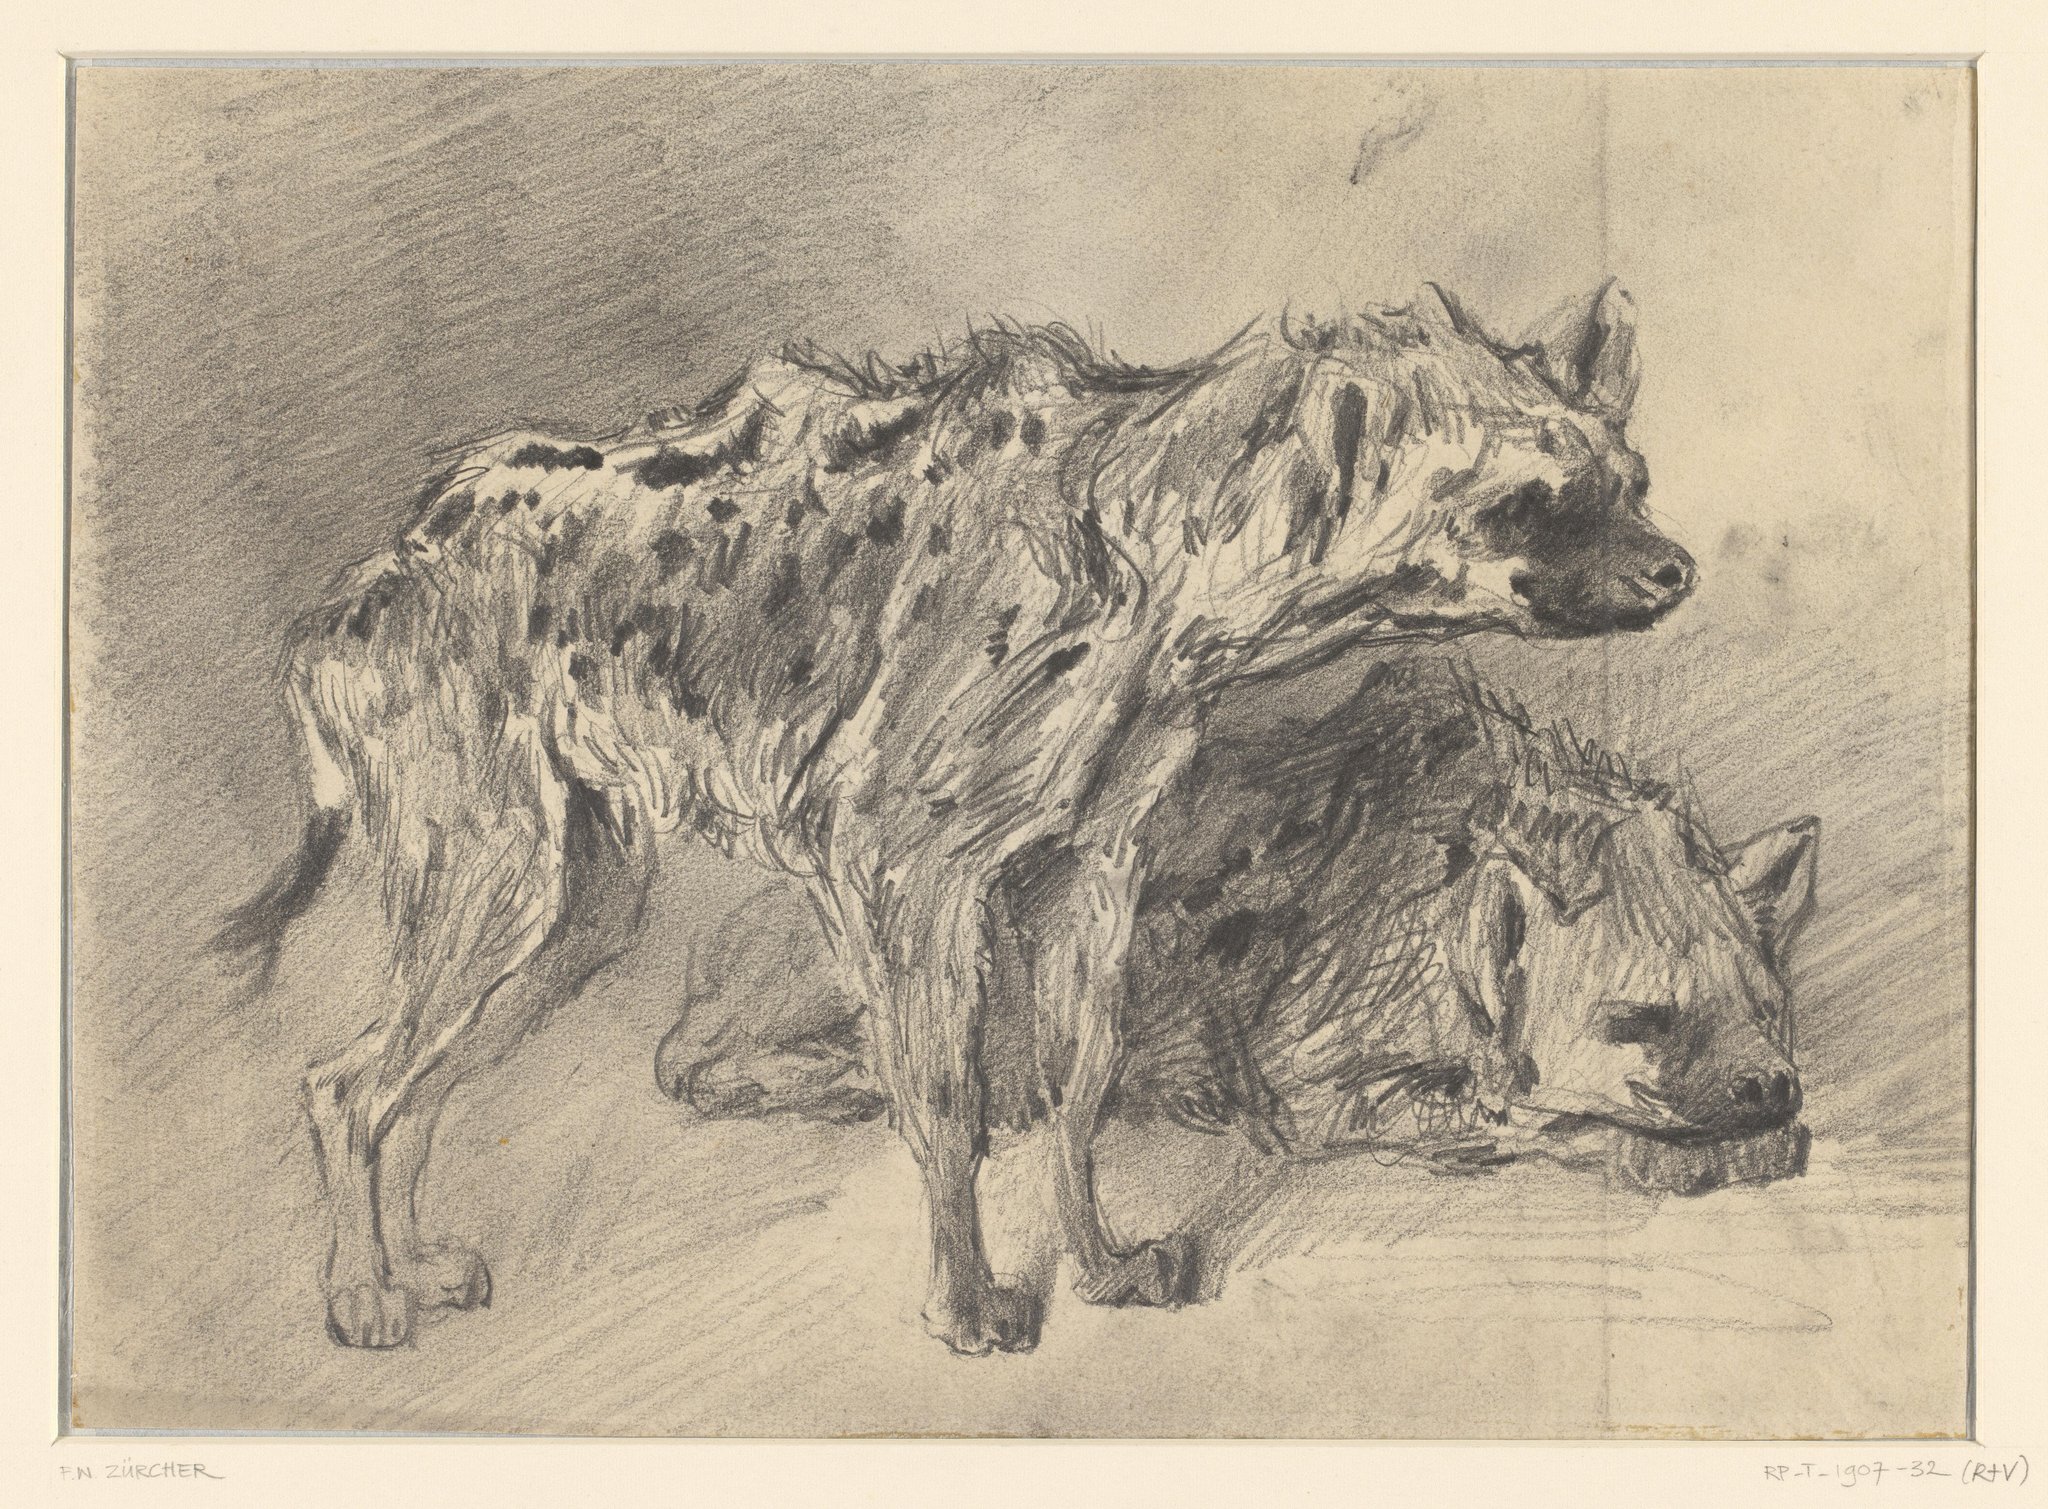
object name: drawing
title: Twee hyena's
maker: frederik willem zürcher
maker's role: draughtsman, print maker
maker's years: 1835-1894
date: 1845-1894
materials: chalk, paper, pencil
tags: beasts of prey, predatory animals: hyena